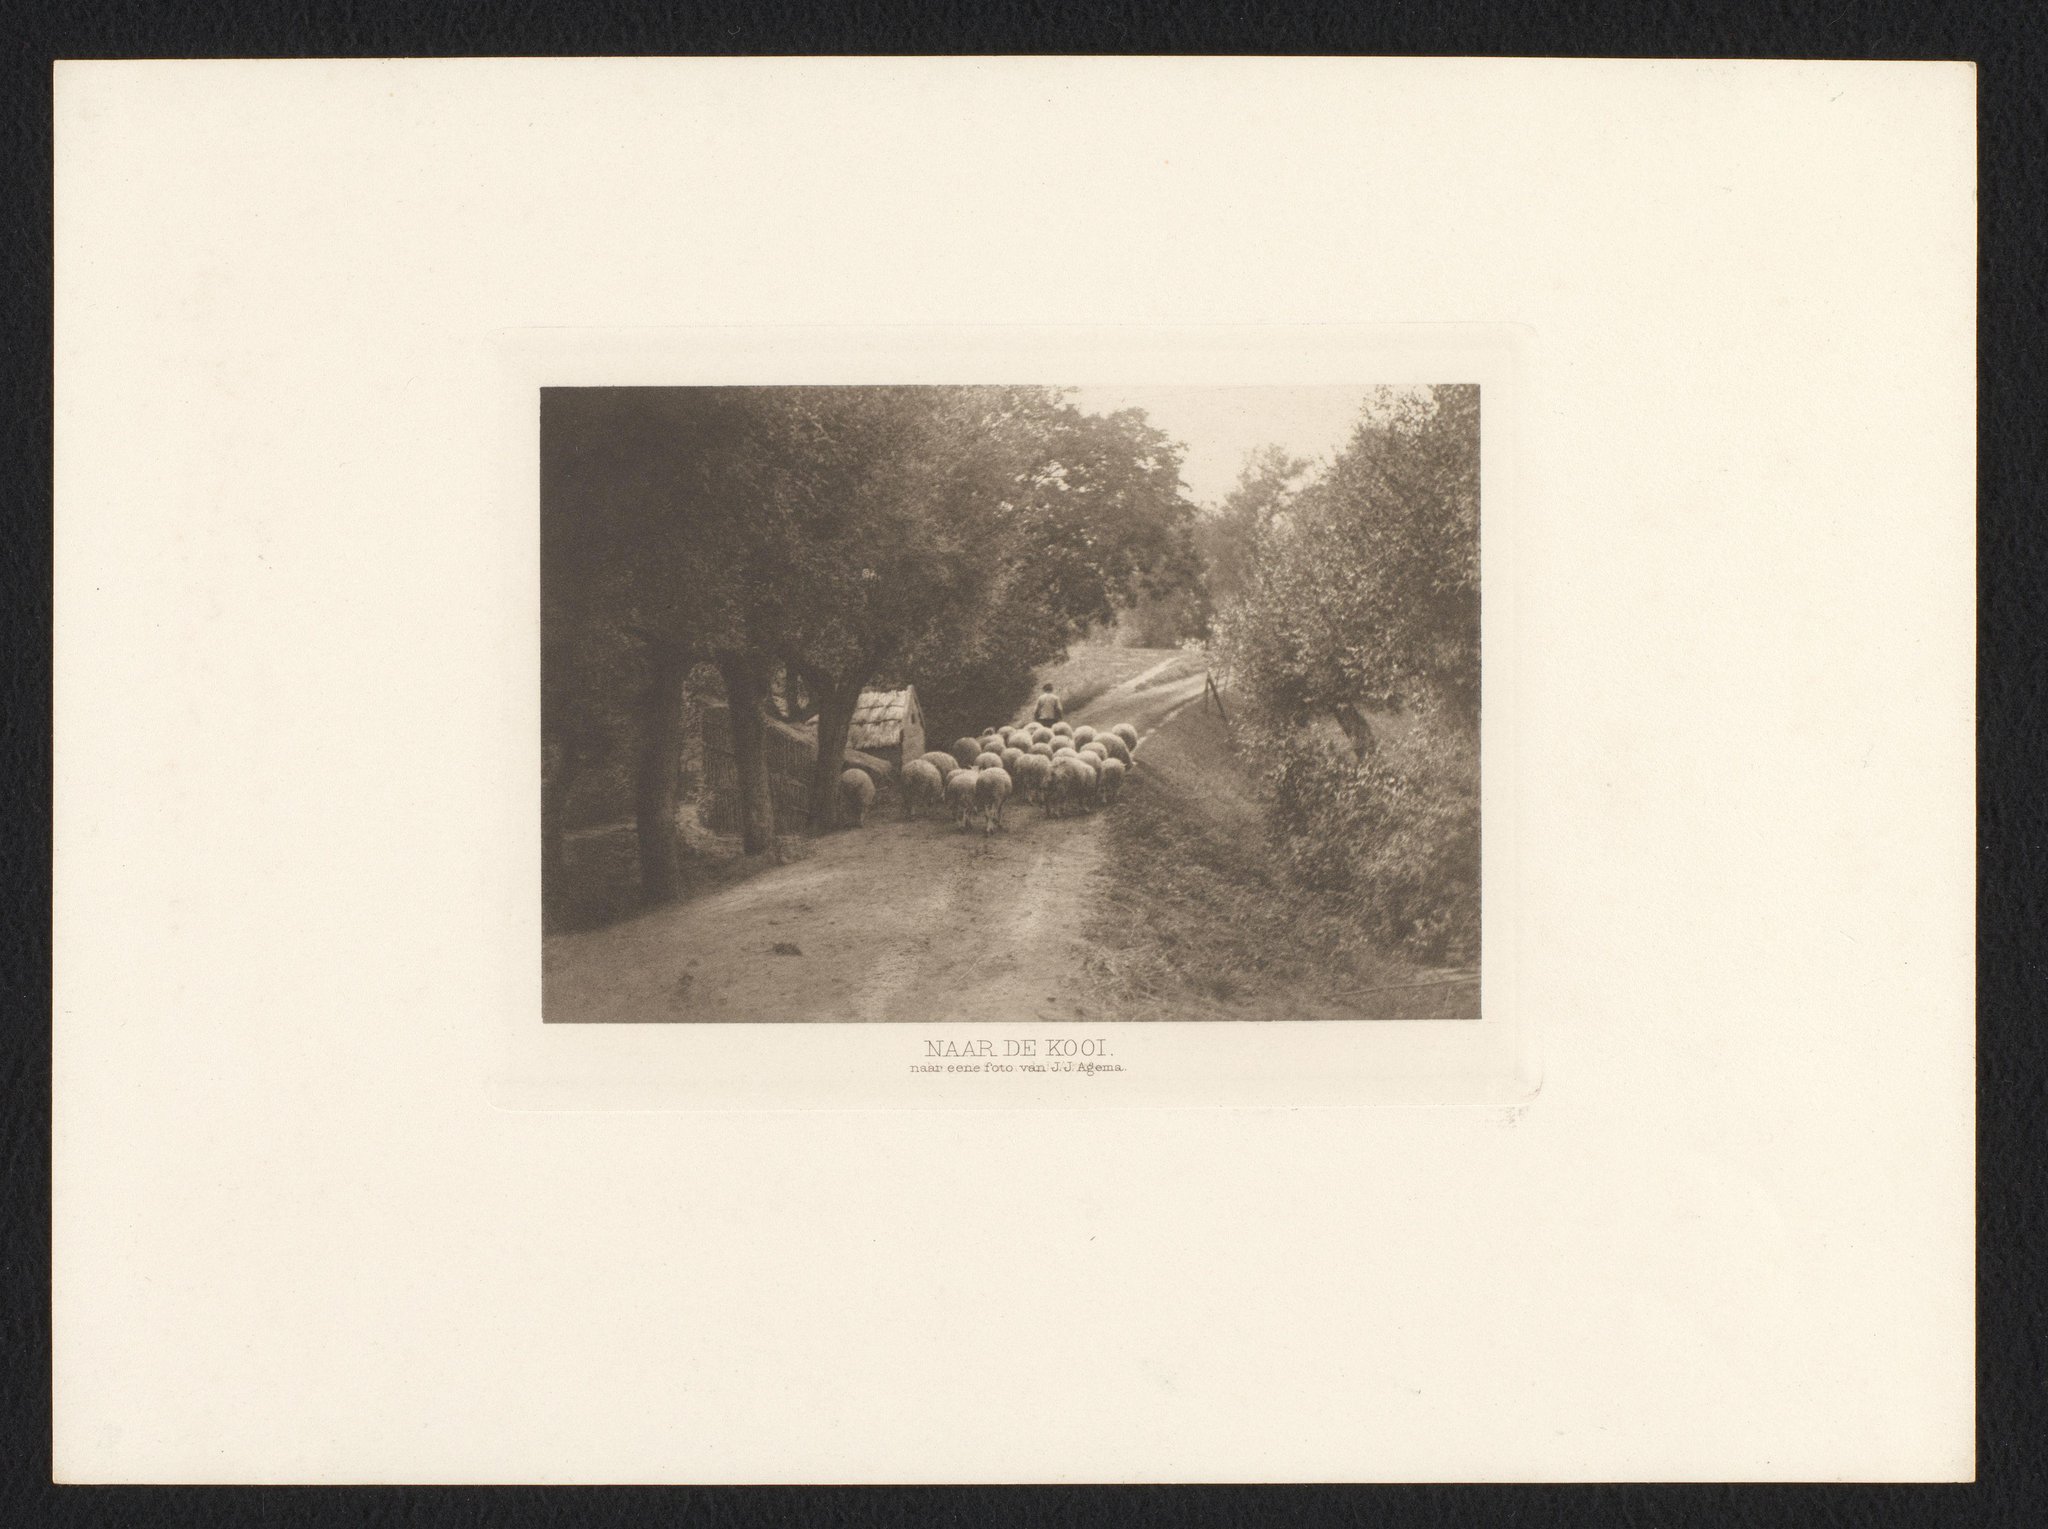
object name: page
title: Herder met kudde schapen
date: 1899-1904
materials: paper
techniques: photoaquatint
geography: netherlands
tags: herding, herdsman, herdswoman, shepherd, shepherdess, cowherd, etc., herd, flock